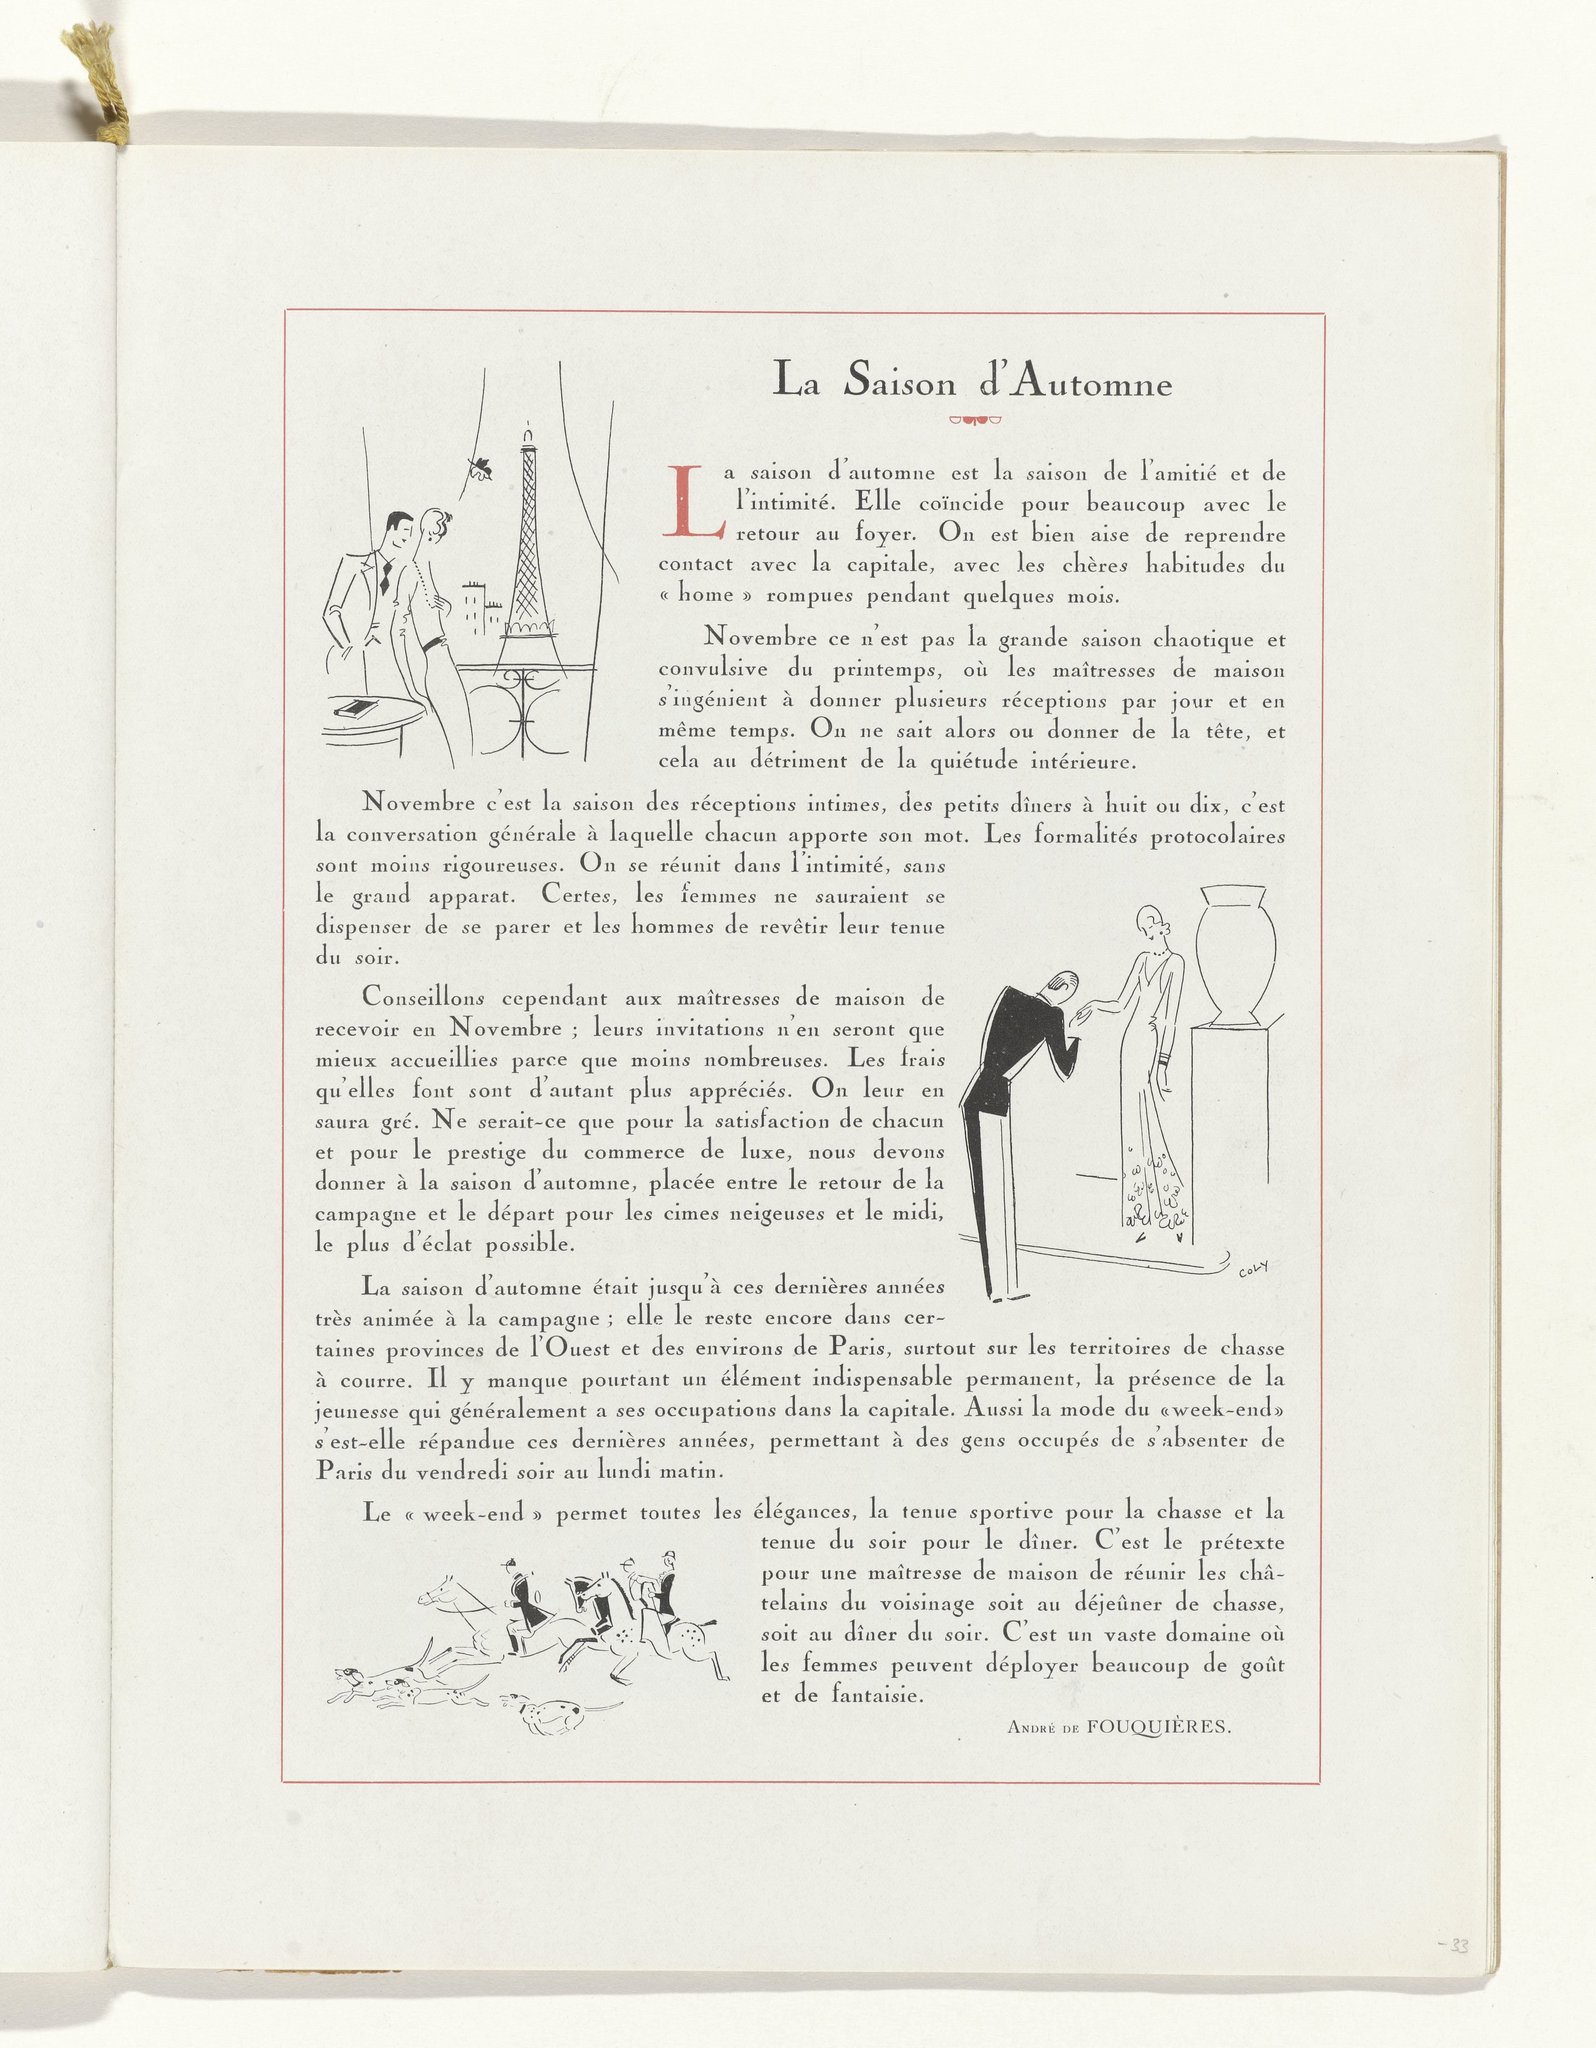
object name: fashion print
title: Art - Goût - Beauté, Feuillets de l' élégance féminine, Novembre 1931, No. 135, 12e Année, p. 33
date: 1931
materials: paper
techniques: printing, photography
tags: fashion plates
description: Tekst 'La Saison d'Automne' met drie illustraties. Pagina uit het modetijdschrift Art-Goût-Beauté (1920-1933).